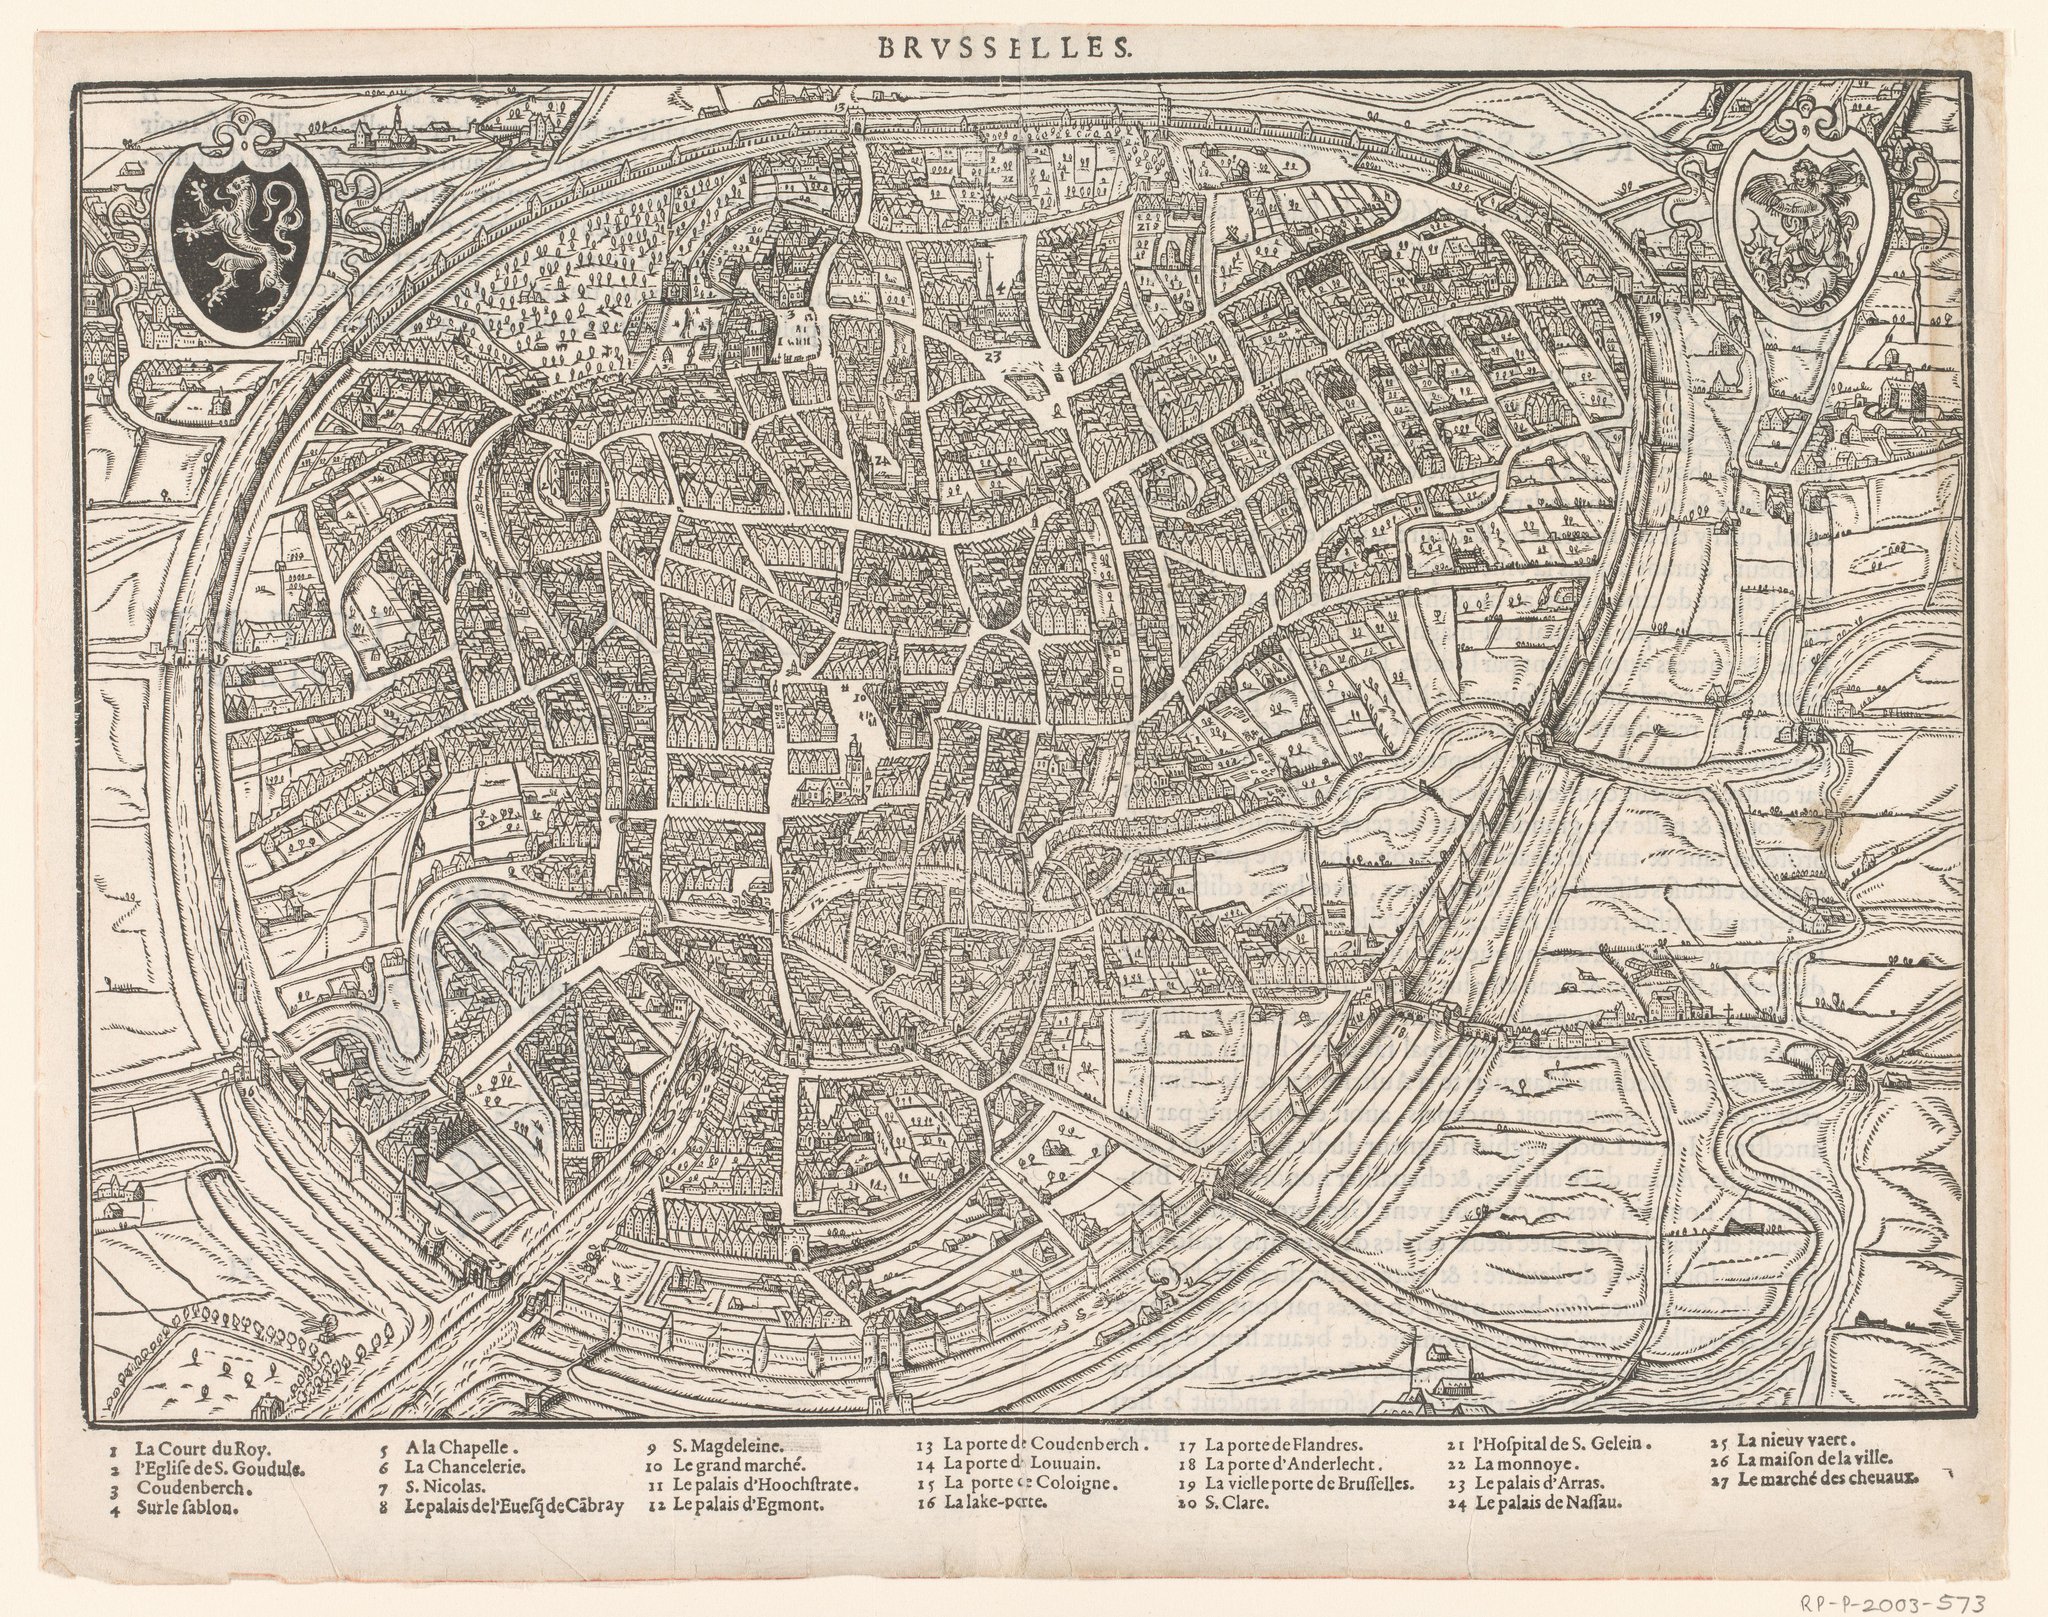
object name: area plan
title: Brusselles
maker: Anonymous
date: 1567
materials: paper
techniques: letterpress printing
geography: antwerp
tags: maps of separate countries or regions, brussels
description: Plattegrond van de stad Brussel. Linksboven het wapen van het hertogdom Brabant, rechtsboven het stadswapen. Onder de voorstelling de legenda 1-27 in boekdruk in het Frans. Bedrukt op de achterzijde met twee bladzijden (p. 74 en 71) met tekst in boekdruk in het Frans. Boekdruk verso rechts: S'Ensuyt le Pourtraict et Description de la Ville de Brusselles / H. Onderdeel van de verzameling kaarten genomen uit een latere editie van: Descrittione di tutti i Paesi Bassi van Lodovico Guicciardini.